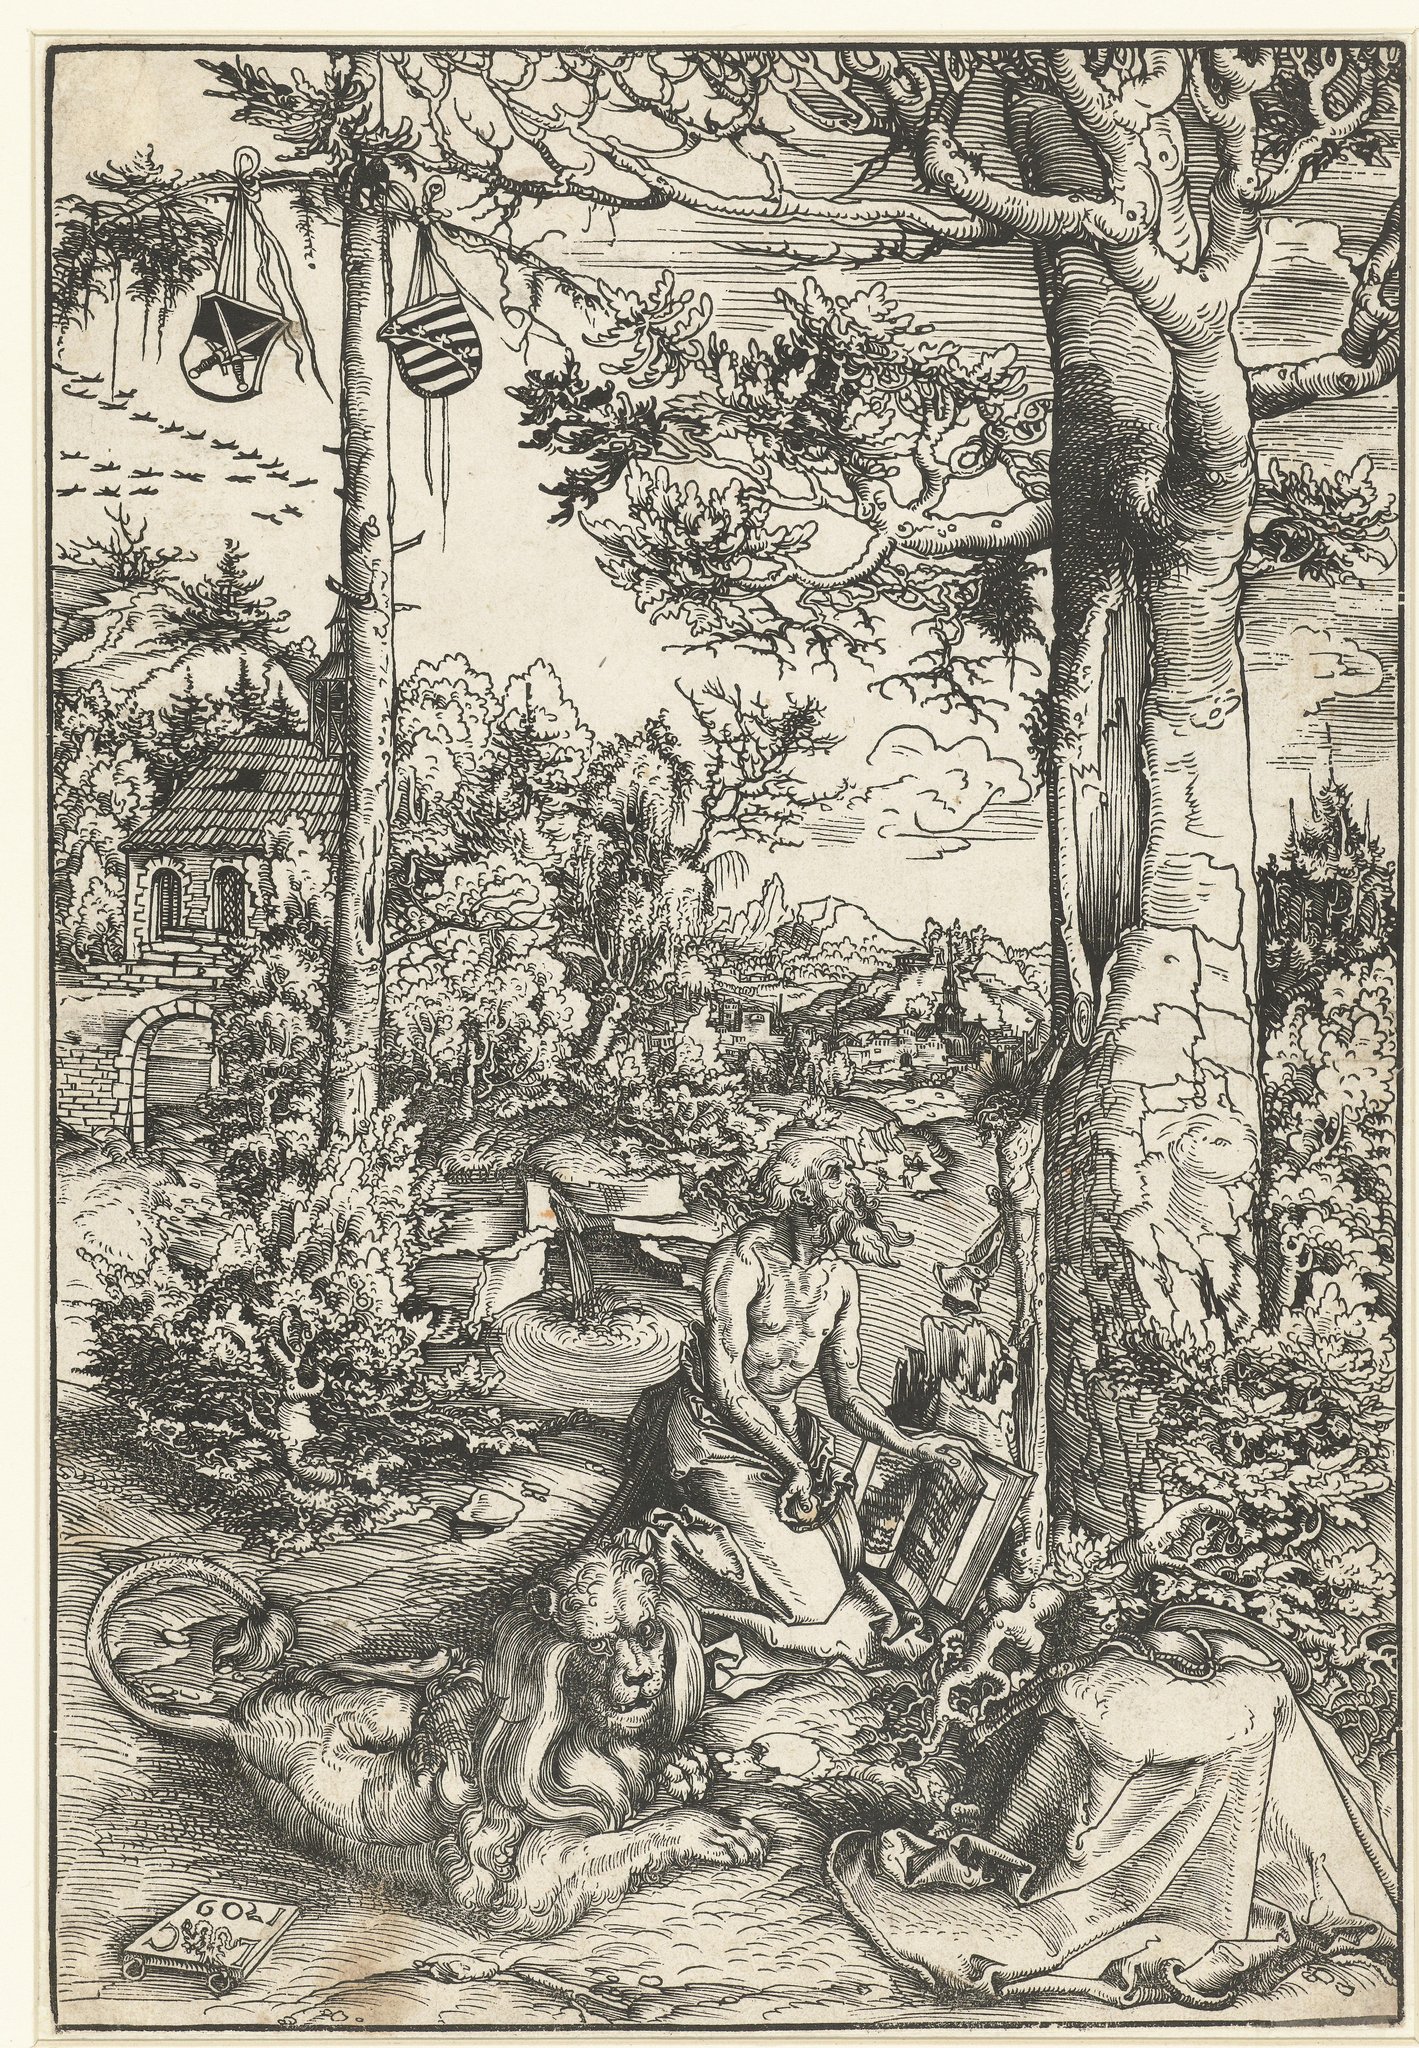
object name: print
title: Heilige Hieronymus als boeteling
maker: lucas cranach (i)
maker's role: draughtsman, print maker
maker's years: 1472-1553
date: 1509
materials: paper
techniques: woodcut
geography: germany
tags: st. jerome as penitent in the desert, half naked, kneeling before a crucifix and holding a stone in his hand to beat his breast; a skull (and other 'vanitas' symbols), sometimes a scorpion and a snake beside him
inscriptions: collector's mark: Lugt 240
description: De heilige Hieronymus knielt voor een crucifix bij een boom. Hij doet boete door zichzelf op zijn blote borst te slaan met de steen die hij vasthoudt. Met zijn linkerhand bladert hij in een boek. Op de voorgrond zijn attributen van de heilige weergegeven, naast hem ligt een leeuw en een kardinaalshoed. Links een vergezicht met een kapel op de oever van en rivier en in de verte een stad in een heuvellandschap. Linksboven in de boom hangen twee schilden met het keurvorstelijk en hertogelijk wapen van Saksen.